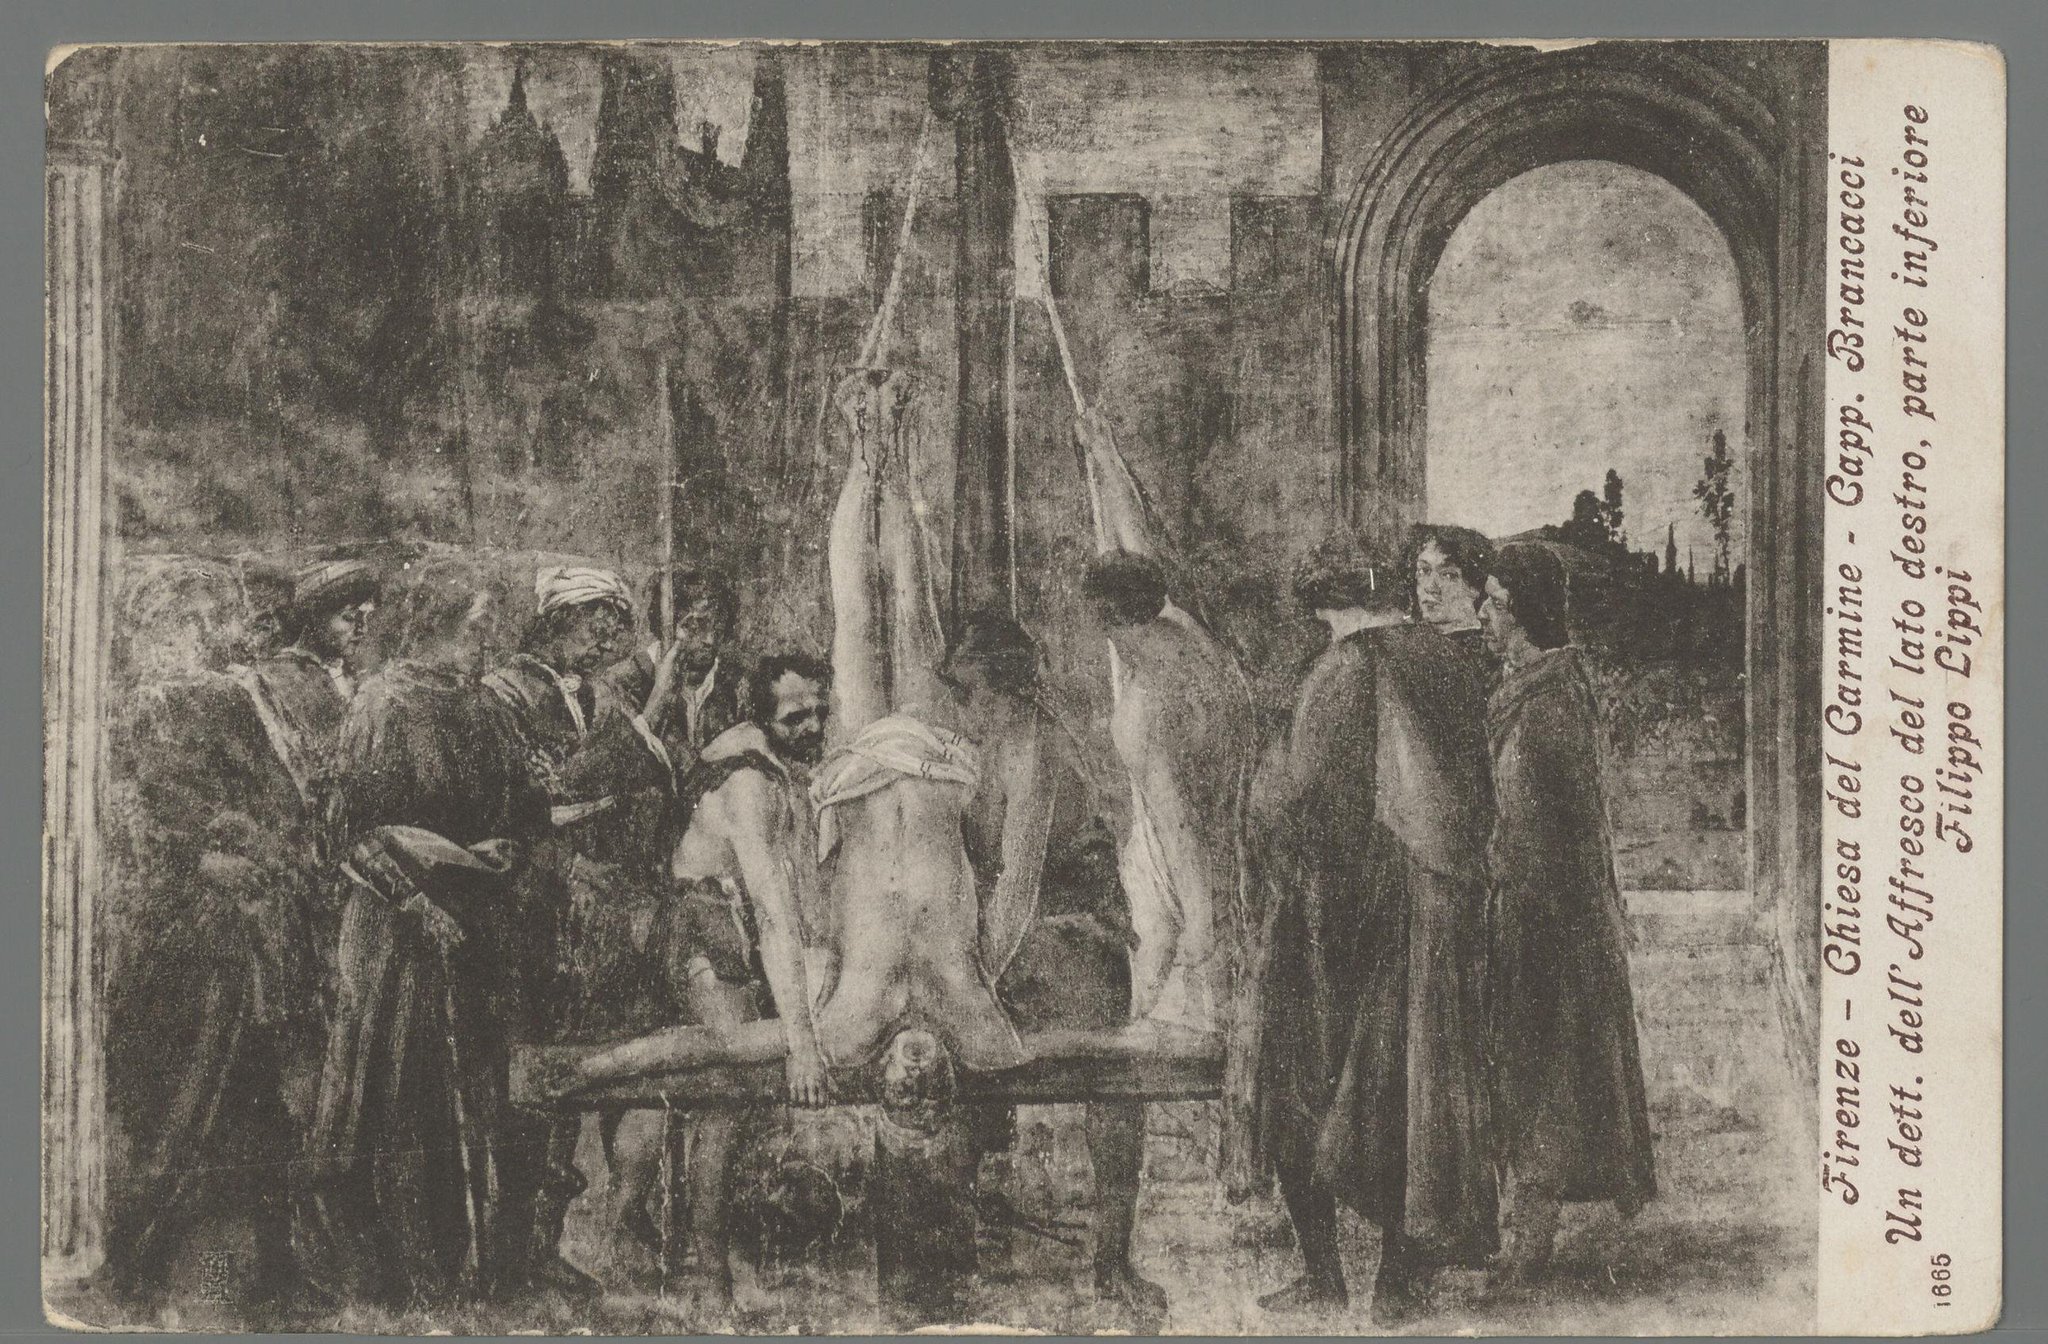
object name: ansichtkaart, prentbriefkaart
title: Firenze. Chiesa del Carmine. Capp. Brancacci. Un dett. dell'Affresco del lato destro, parte inferiore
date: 1906-1930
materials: cardboard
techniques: photograph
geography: florence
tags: interior of church, picture, painting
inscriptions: collector's mark: ‘AFE v S’